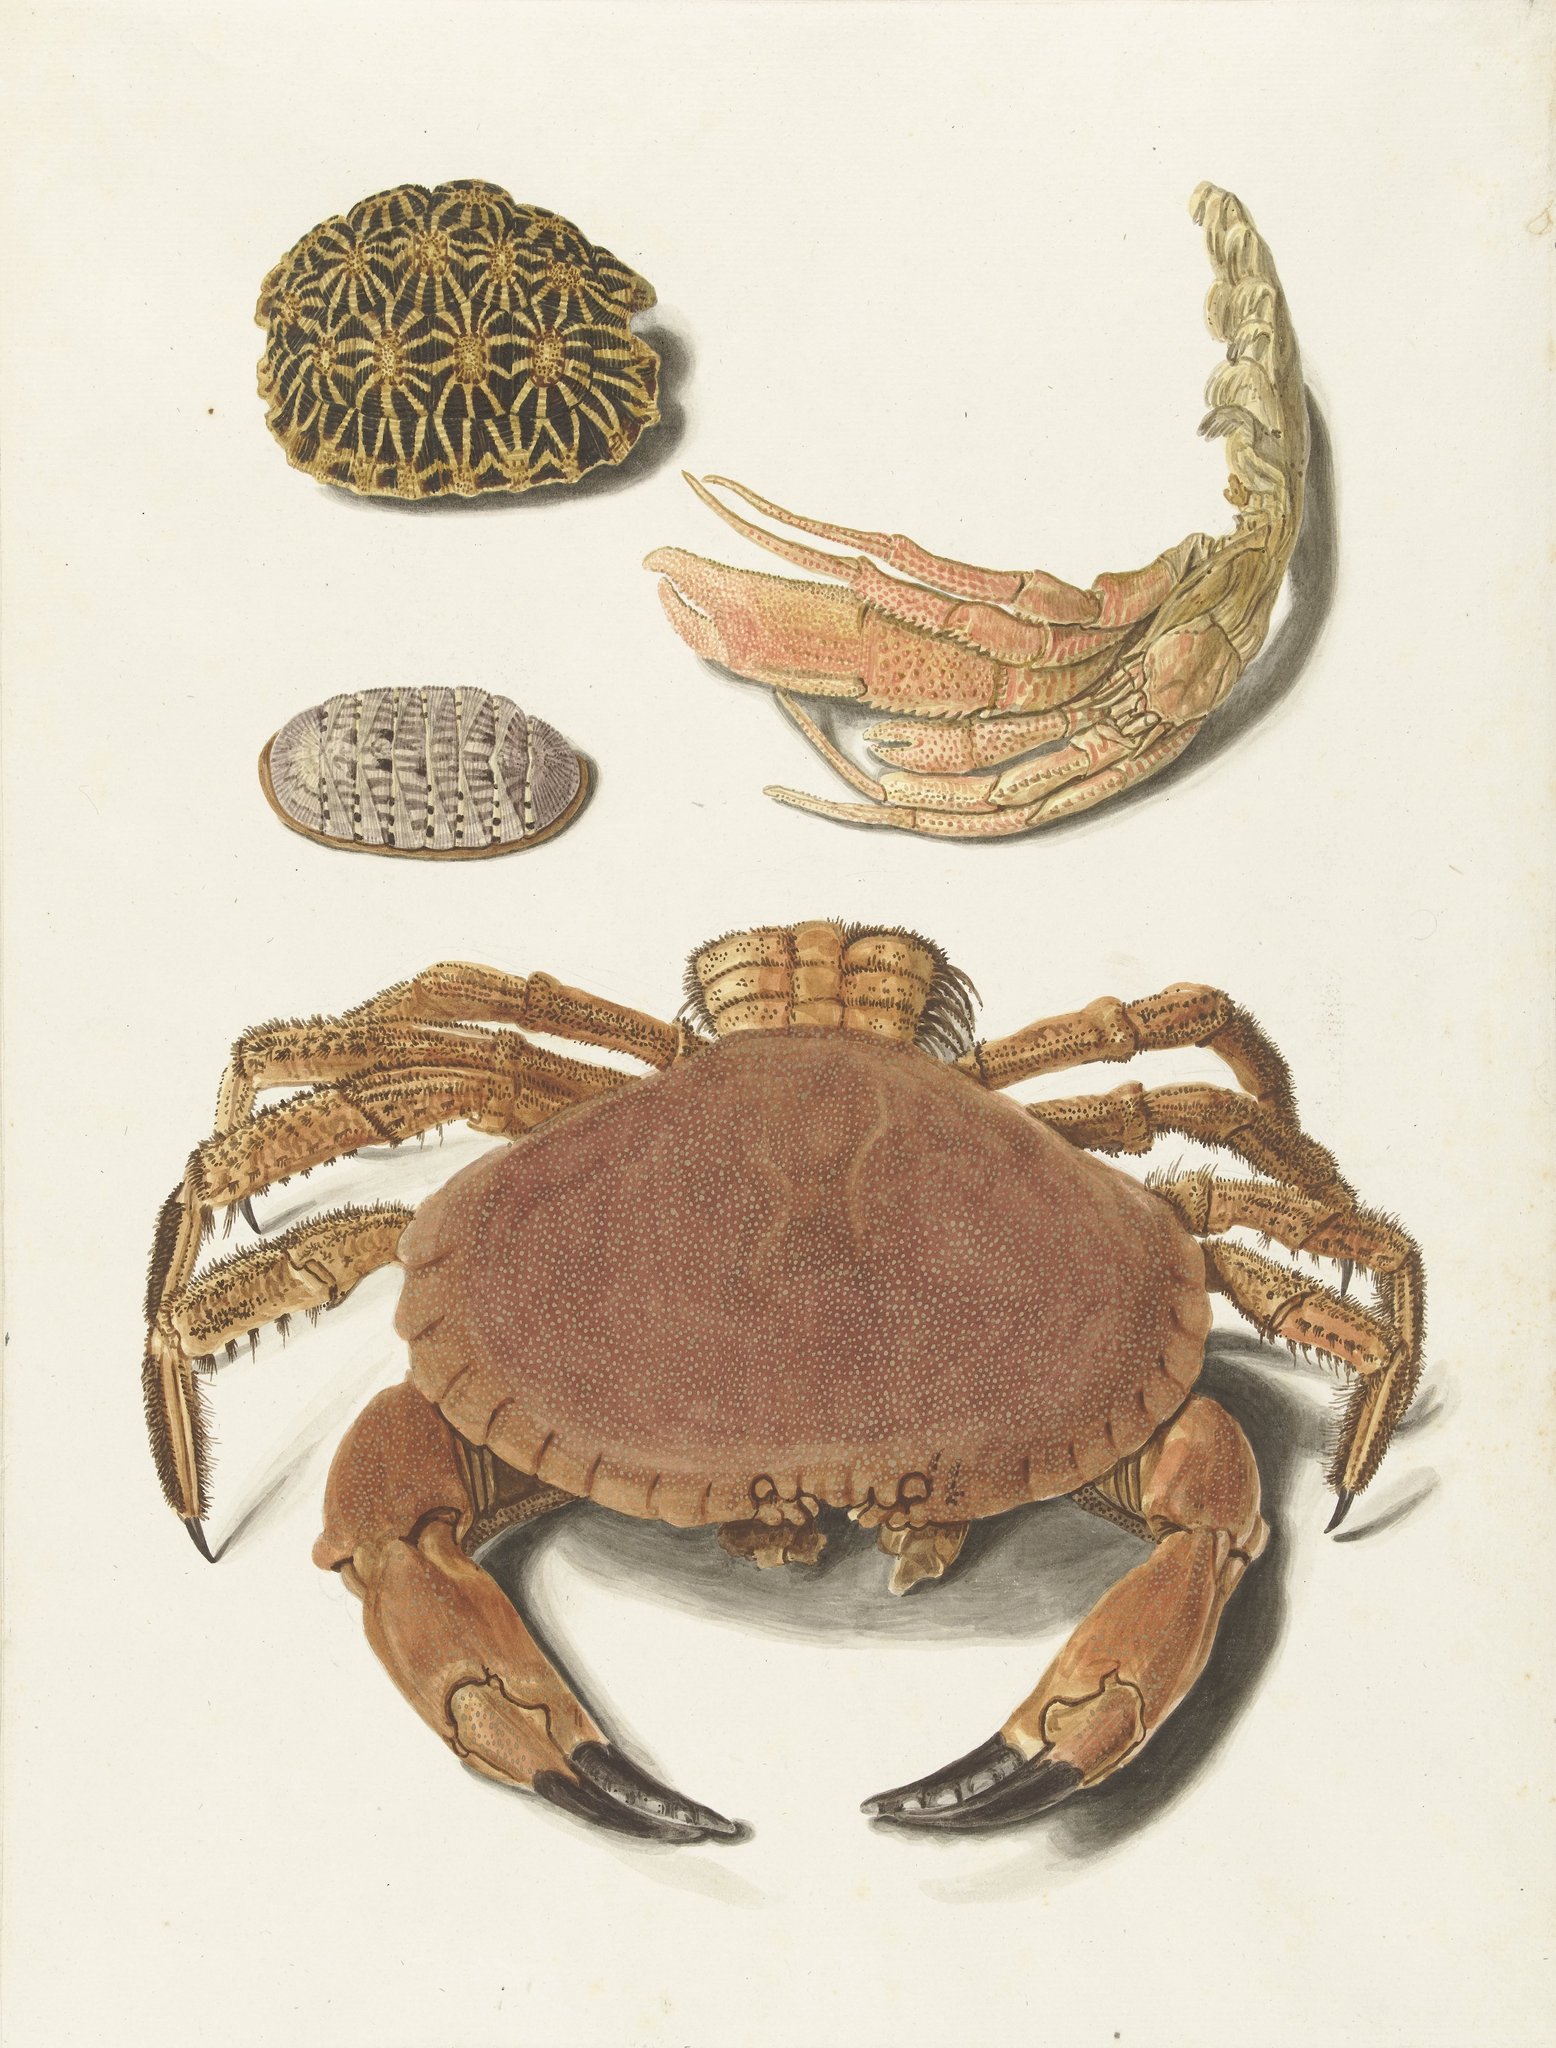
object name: watercolor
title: Een krab, een schaar van een krab en twee schilden van schildpadden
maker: johann gustav hoch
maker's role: painter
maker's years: 1716-1779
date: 1726-1779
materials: paper, pencil, watercolor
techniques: brush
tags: tortoises, turtles (+ shell, snail-shell etc.), crustaceans: crab